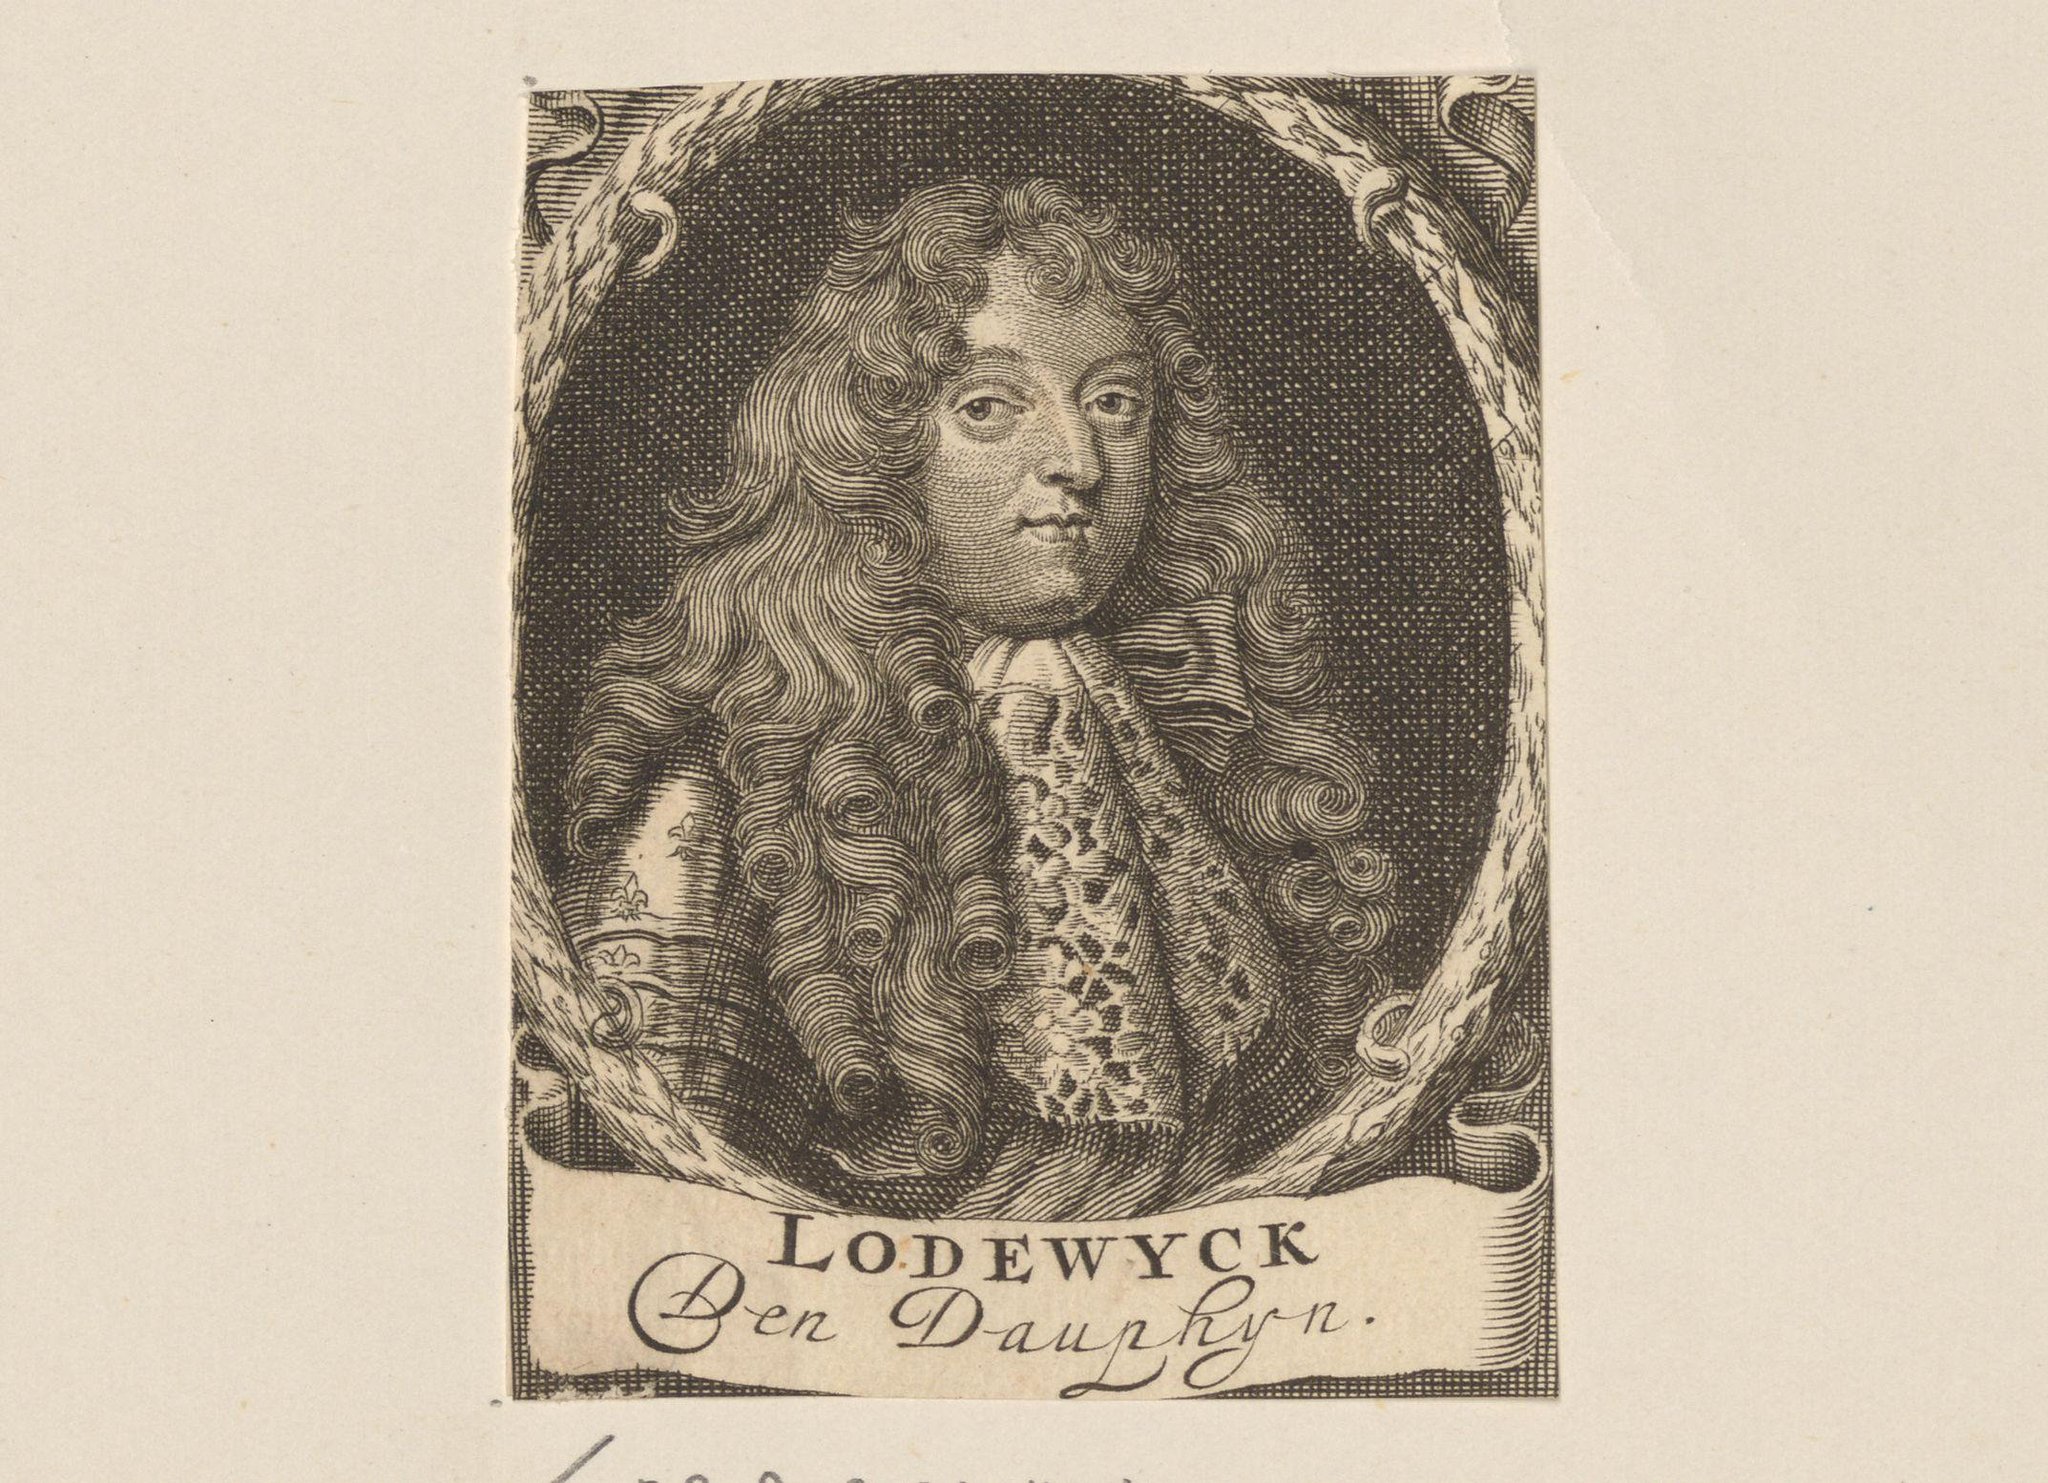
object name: print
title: Portret van Lodewijk, dauphin van Frankrijk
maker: Anonymous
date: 1700-1799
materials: paper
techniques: engraving, etching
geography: low countries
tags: dauphin van frankrijk lodewijk, historical persons, crown prince